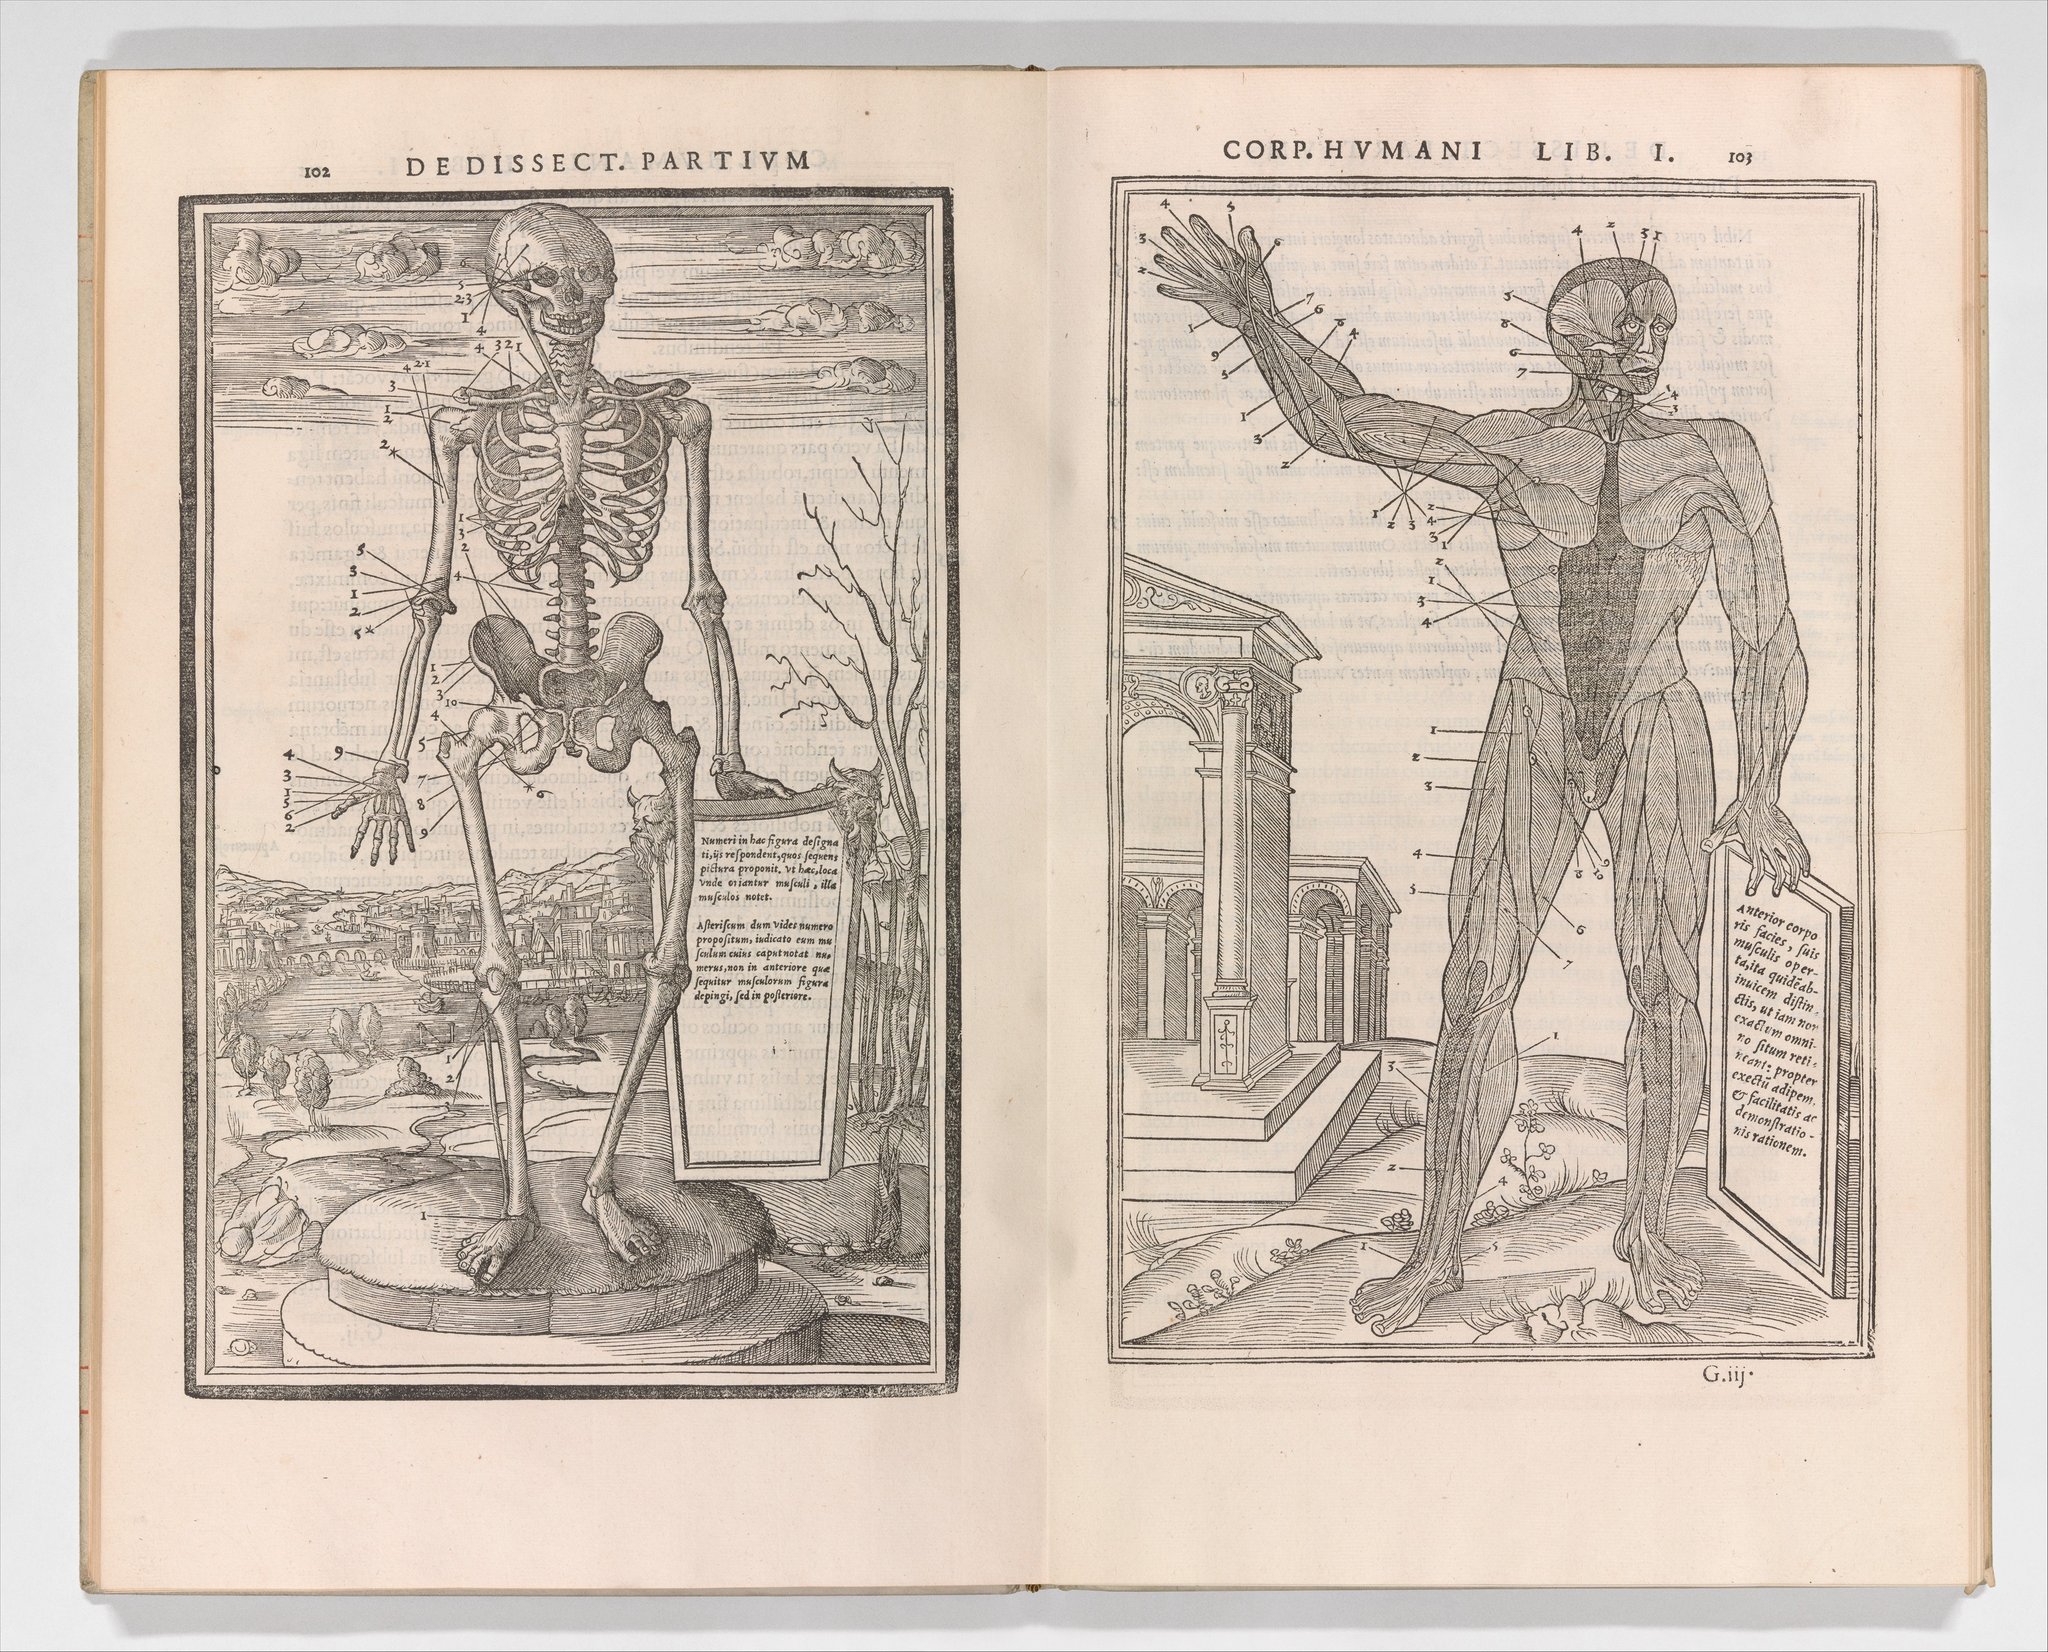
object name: book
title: De dissectione partium corporis humani libri tres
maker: charles estienne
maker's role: author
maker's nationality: french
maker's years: 1499-1564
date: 1545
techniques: woodcut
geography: france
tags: human anatomy,skeletons